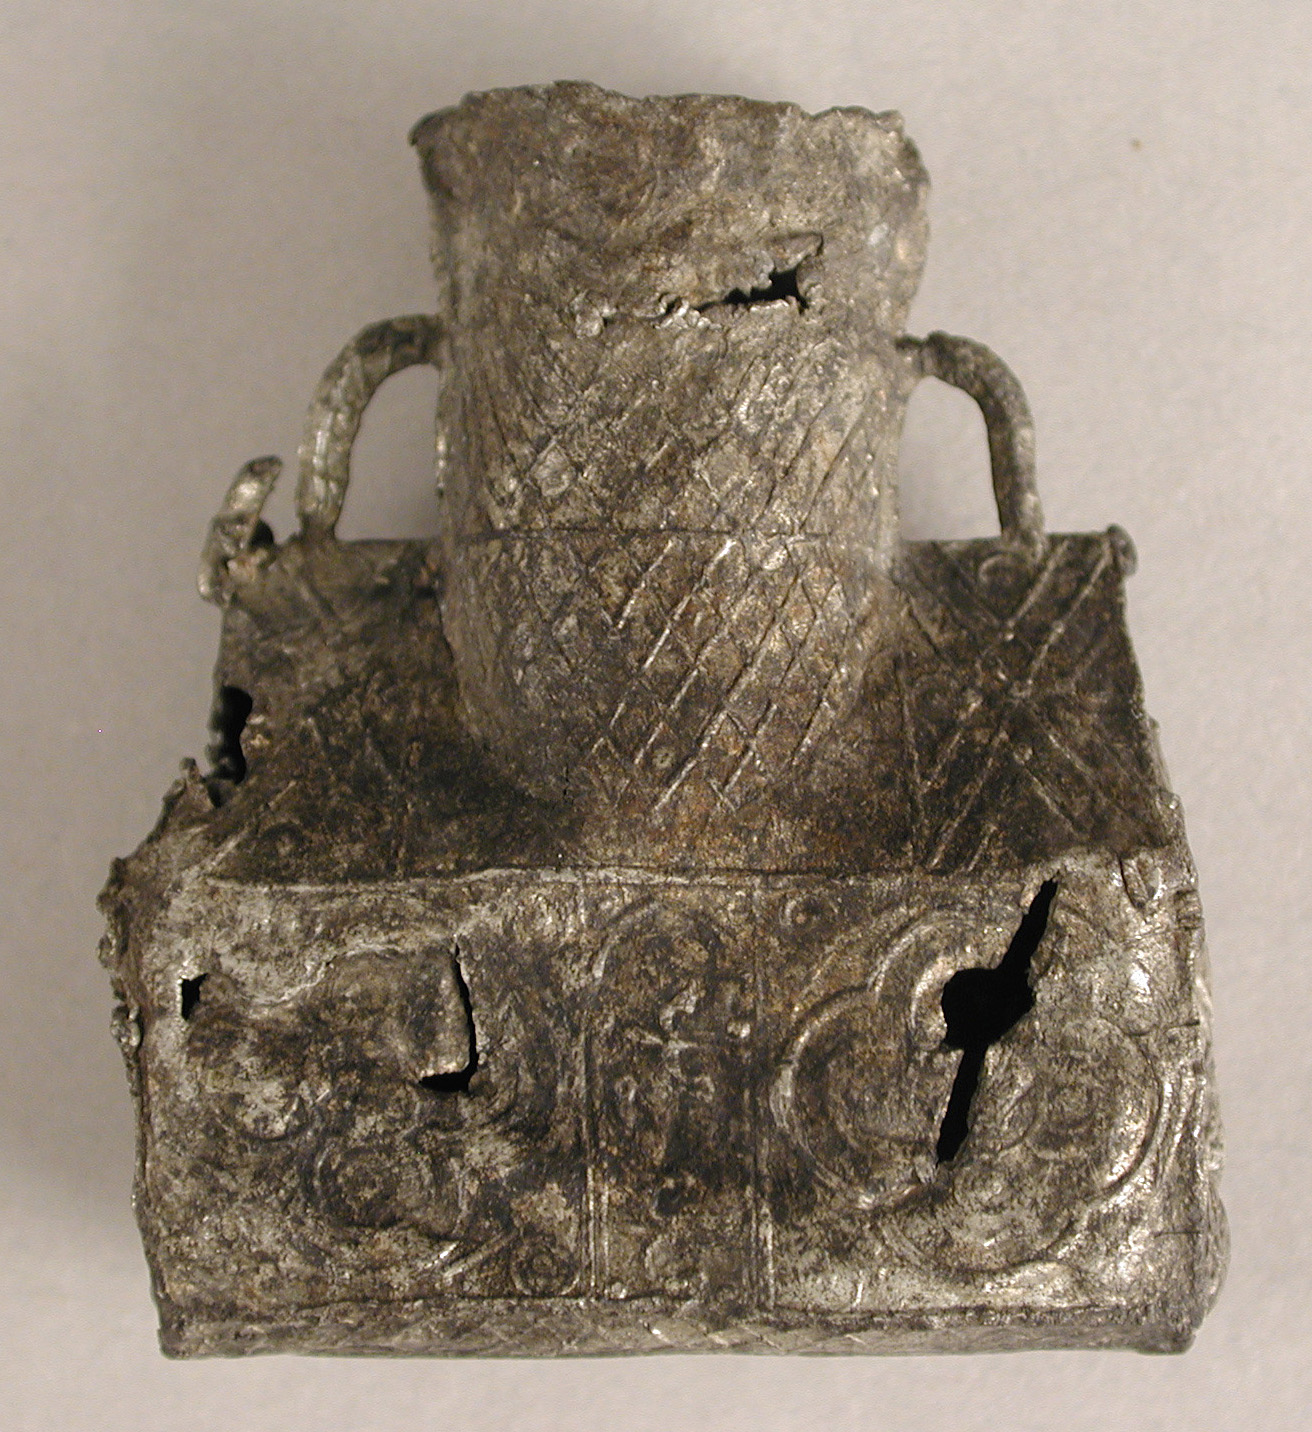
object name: ampulla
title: Ampule, Becket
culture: british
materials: tin